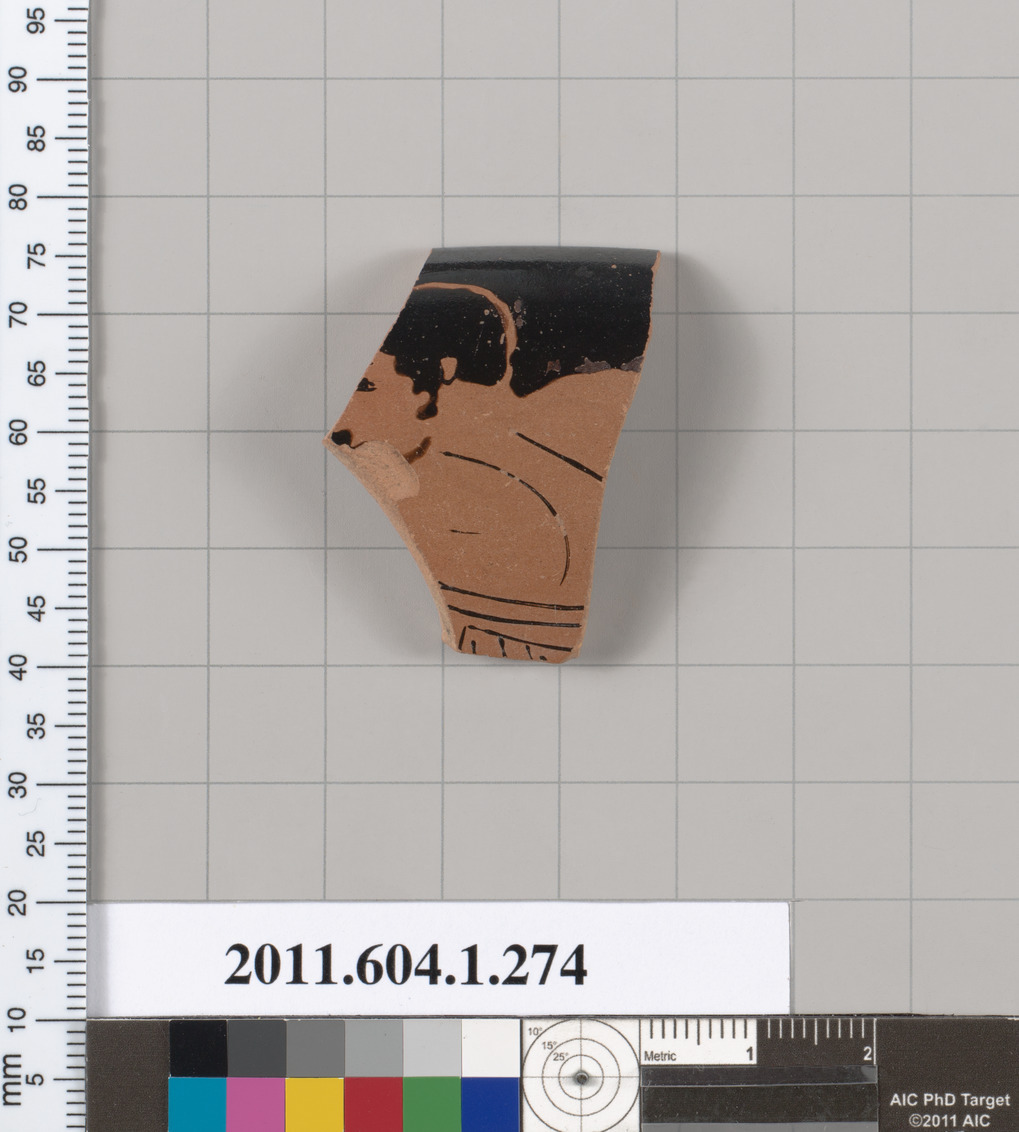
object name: kylix fragment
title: Terracotta rim fragment of a kylix (drinking cup)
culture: greek, attic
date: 475-451 BCE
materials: terracotta